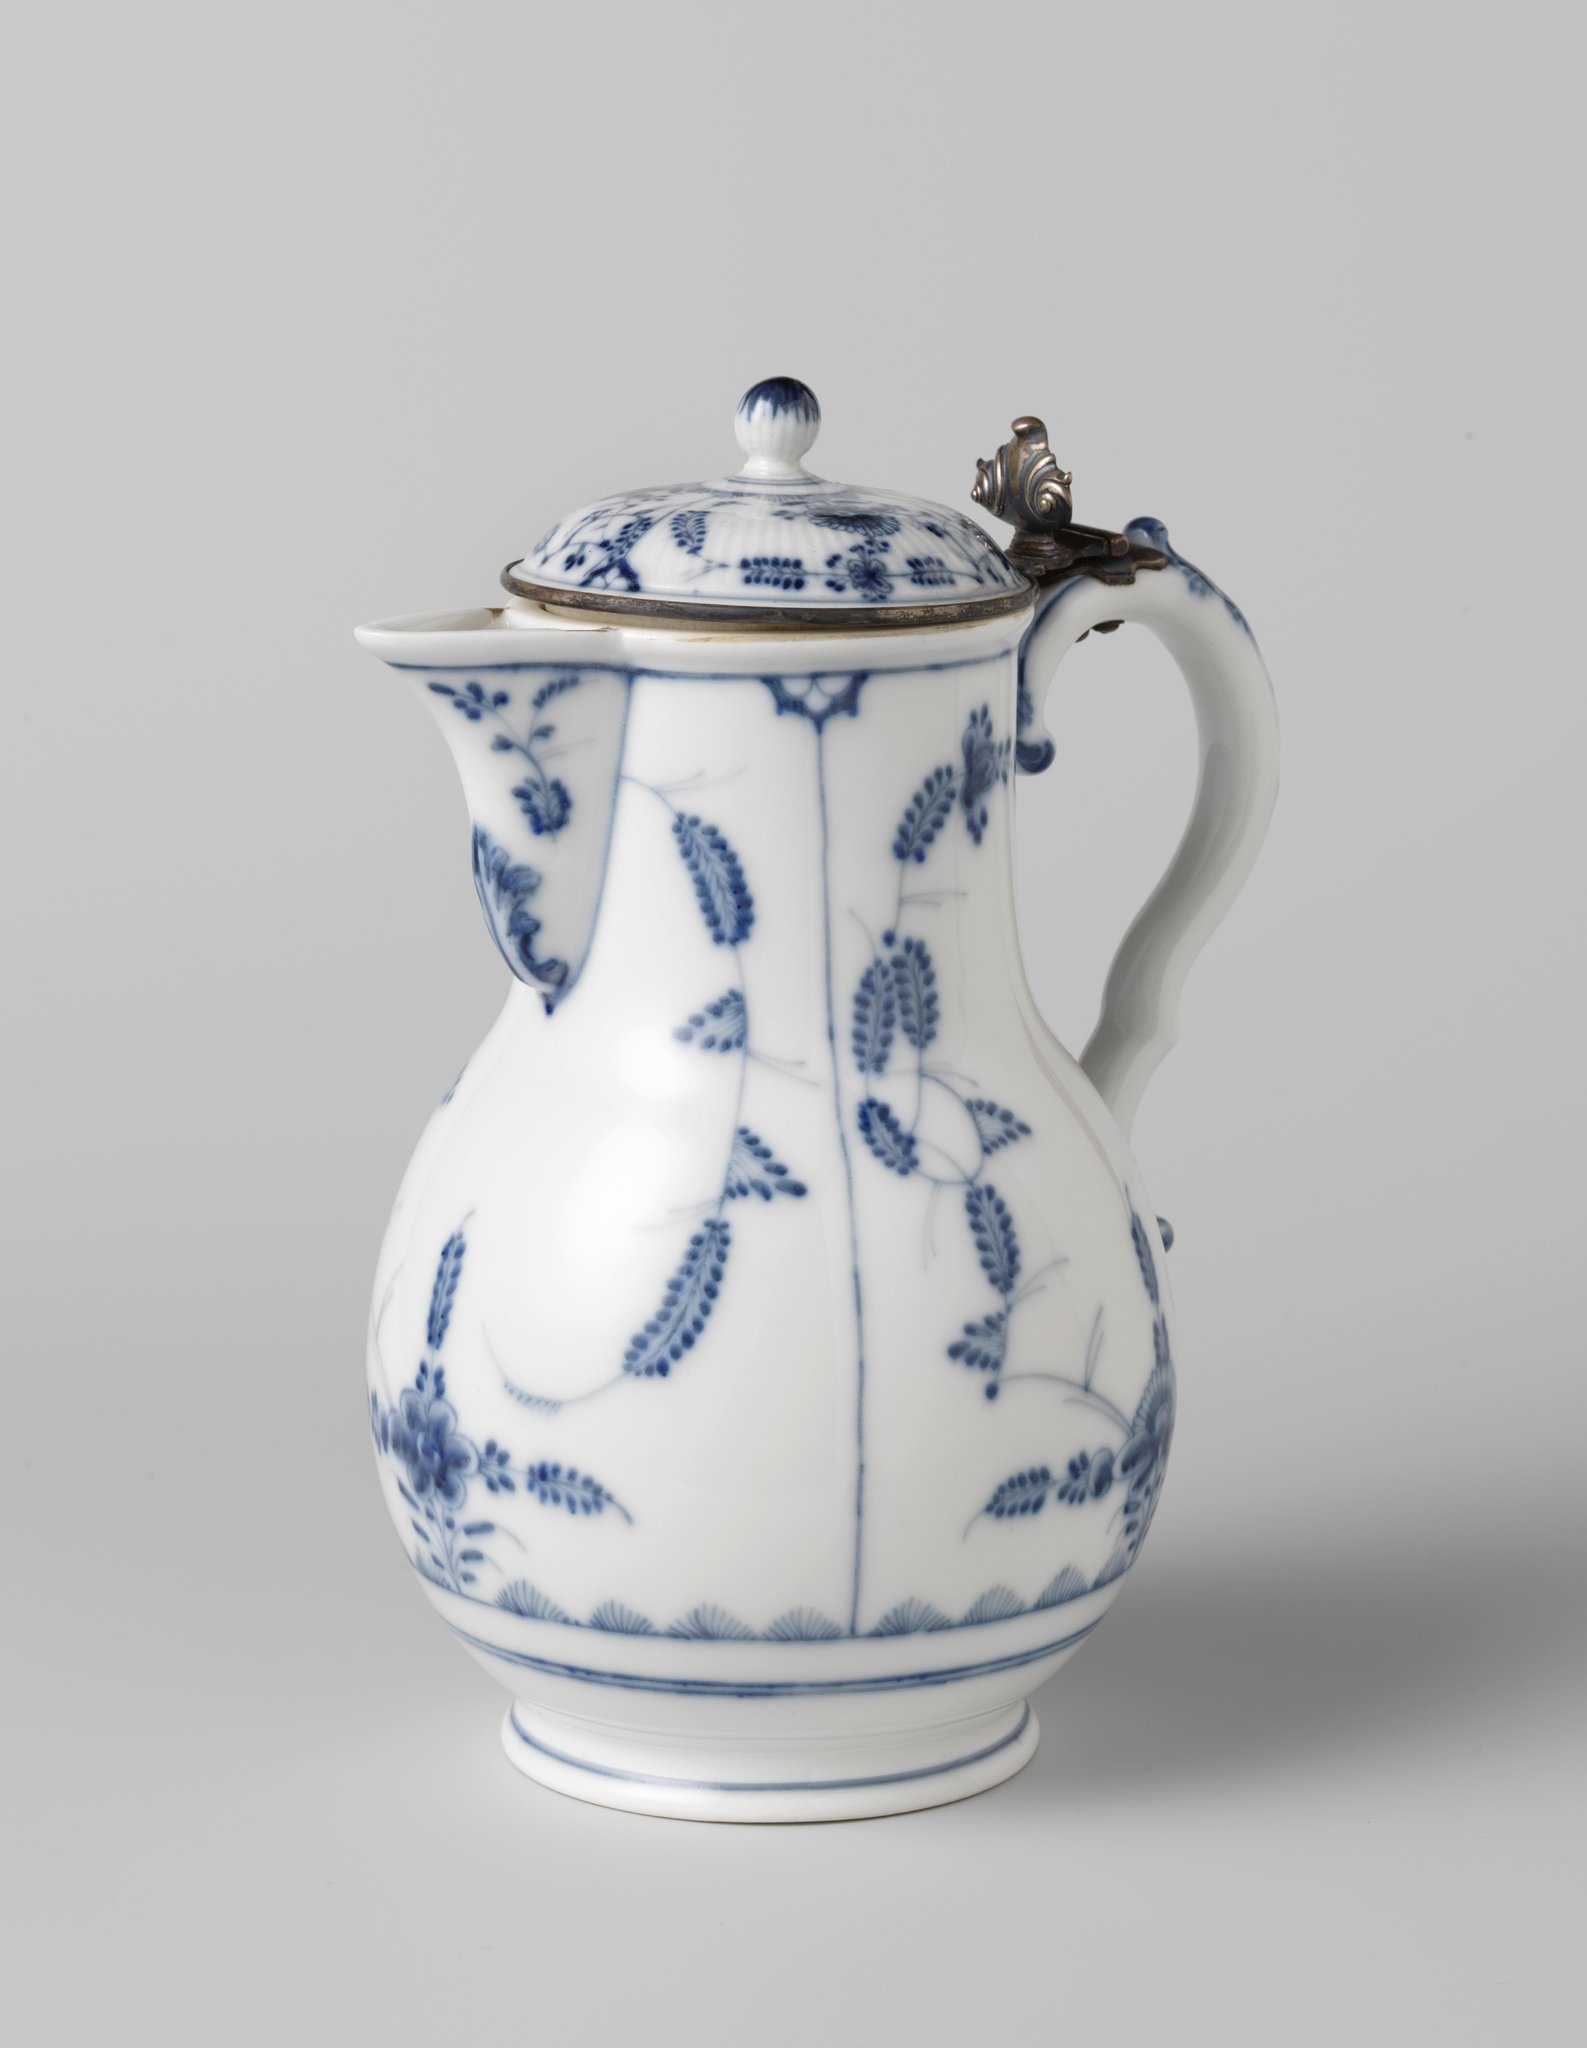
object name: coffee pot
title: Koffiekan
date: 1774-1784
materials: porcelain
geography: loosdrecht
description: Porcelain from the factory of Joannes de Mol at Loosdrecht. Coffee pot Decorated in underglaze blue. Loosdrecht, c. 1778 - 1782.